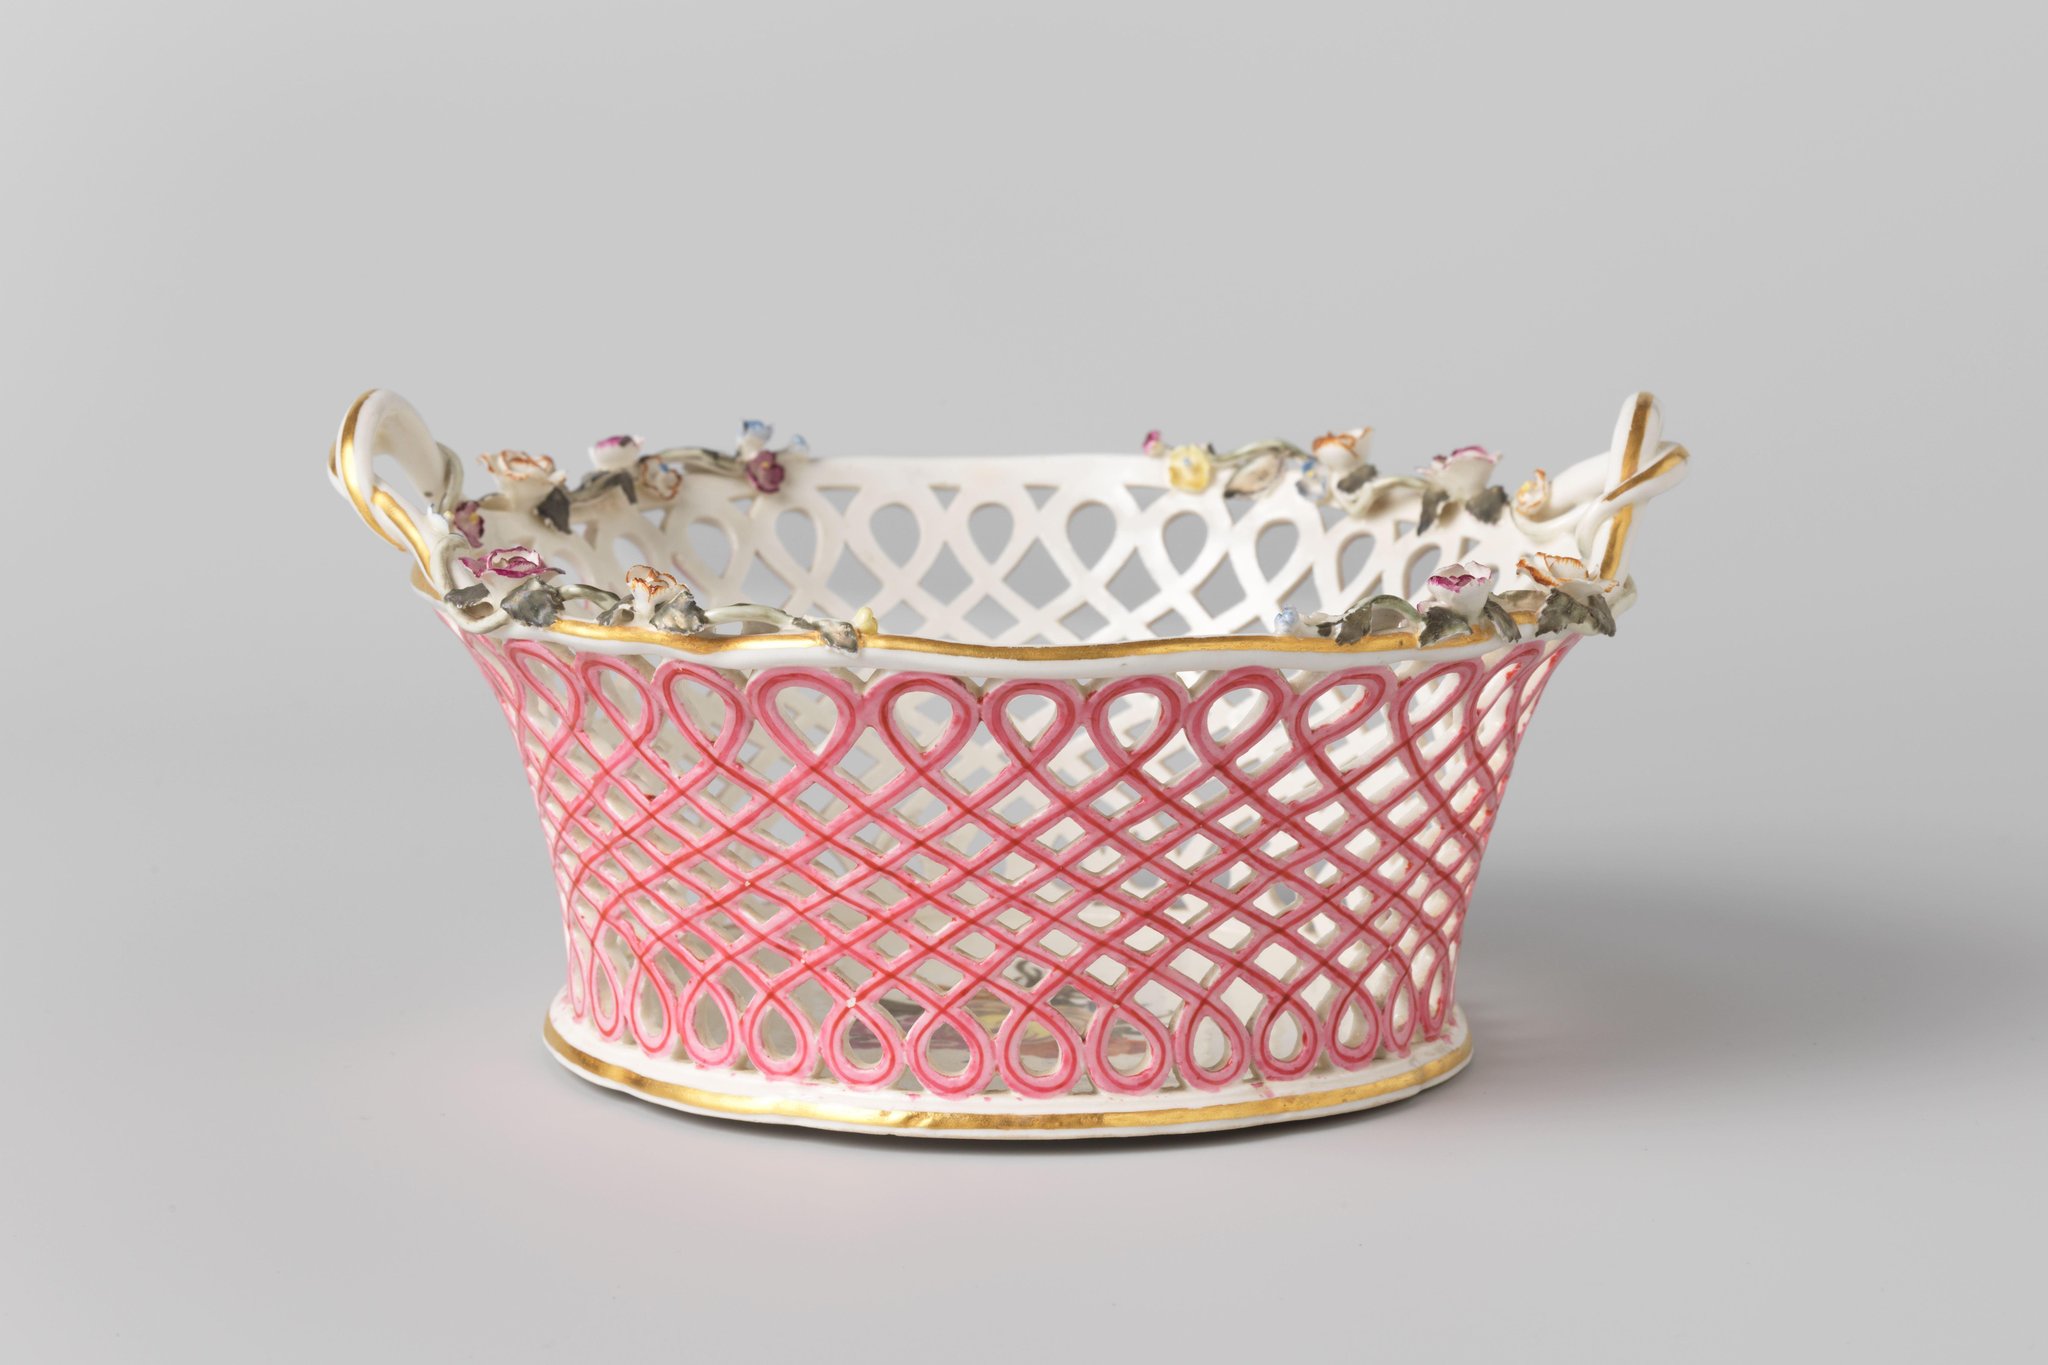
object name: basket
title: Mand, beschilderd met een veelkleurig bloemboeket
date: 1778-1782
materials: porcelain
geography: loosdrecht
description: Two baskets. Porcelain. Loosdrecht, c. 1778 - 1782. Factory of Joannes de Mol.